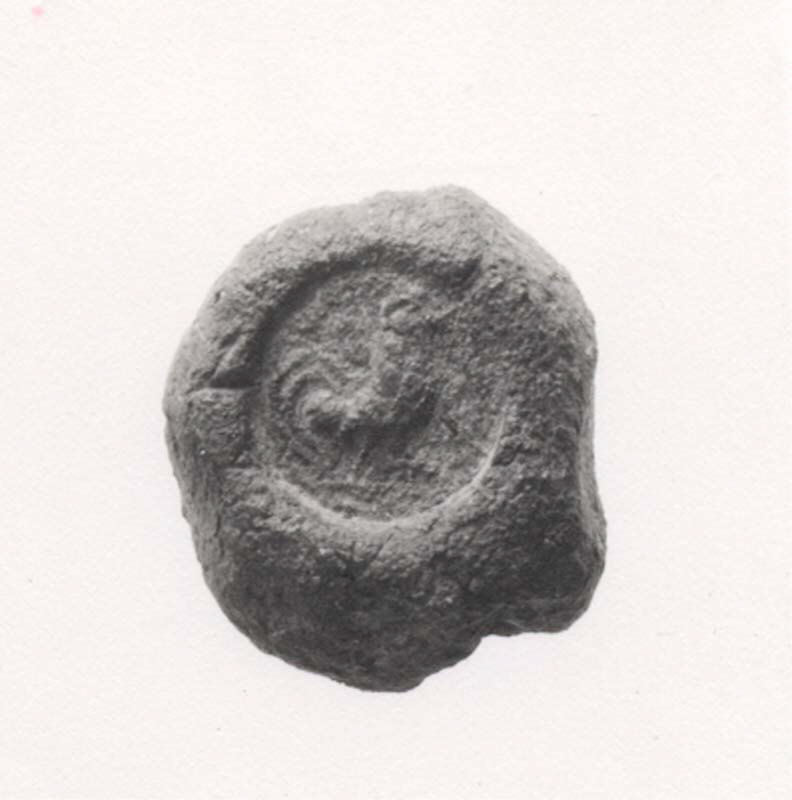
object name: sealing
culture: sasanian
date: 601-700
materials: clay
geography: iran